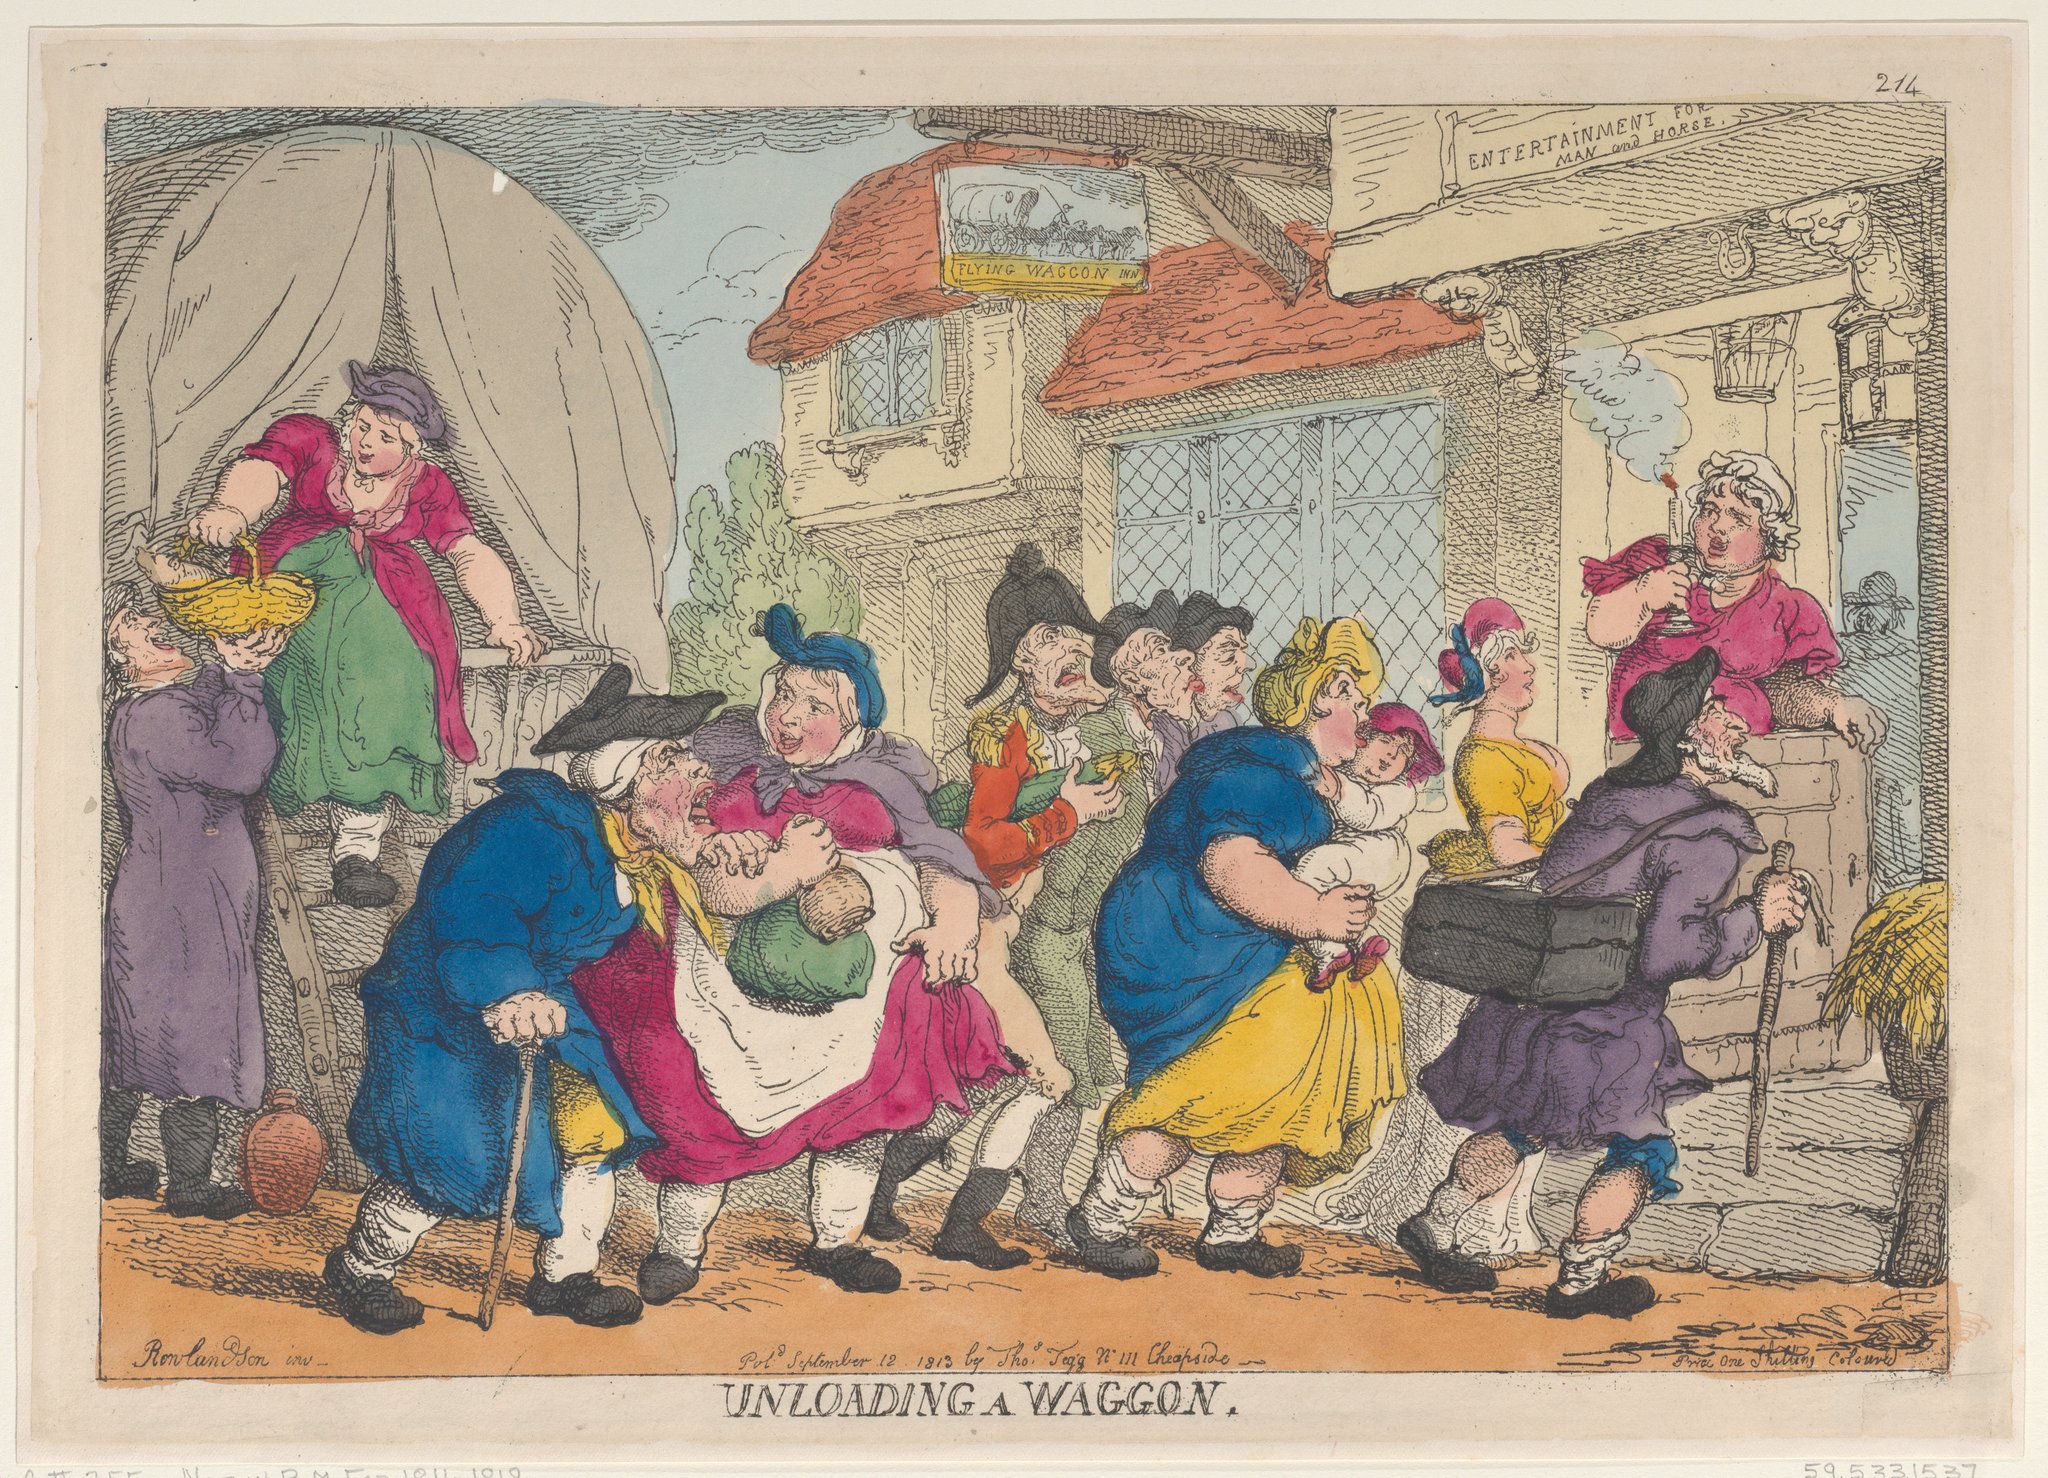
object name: print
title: A Doleful Disaster, or Miss Fubby Fatarmin's Wig Caught Fire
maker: thomas rowlandson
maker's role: artist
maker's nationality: british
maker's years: 1757-1827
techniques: etching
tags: satire,men,women